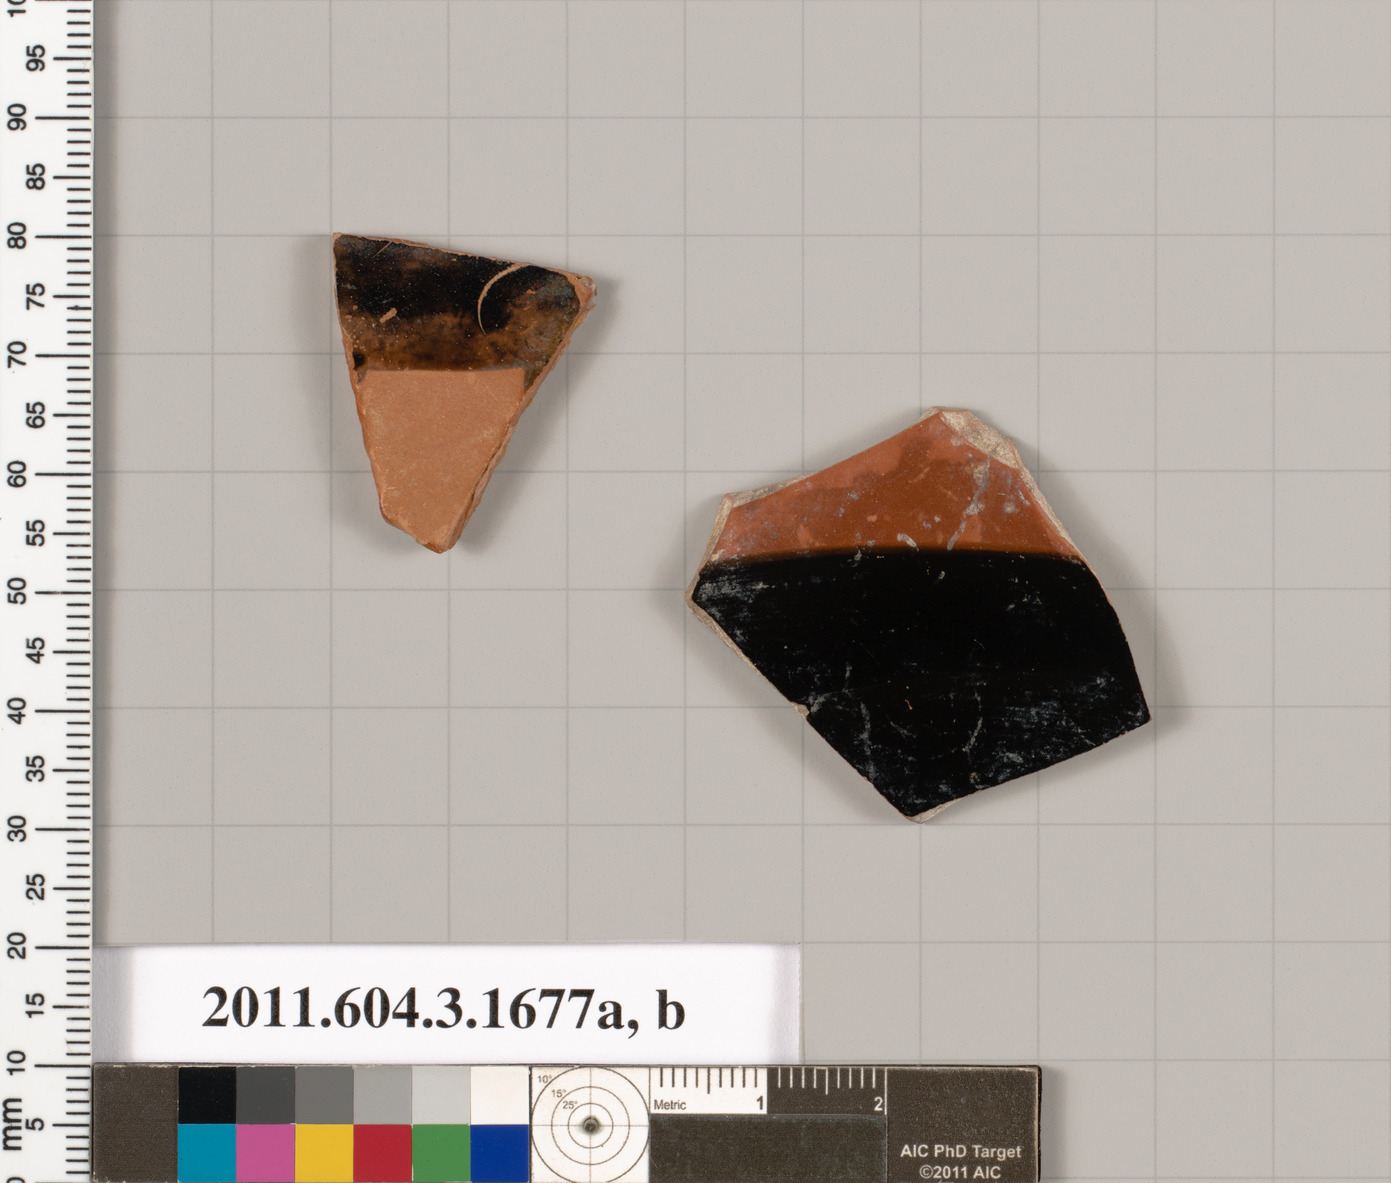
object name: kylix fragment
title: Terracotta fragments of kylikes: Band or lip cups (drinking cups)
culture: greek, attic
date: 550-526 BCE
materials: terracotta